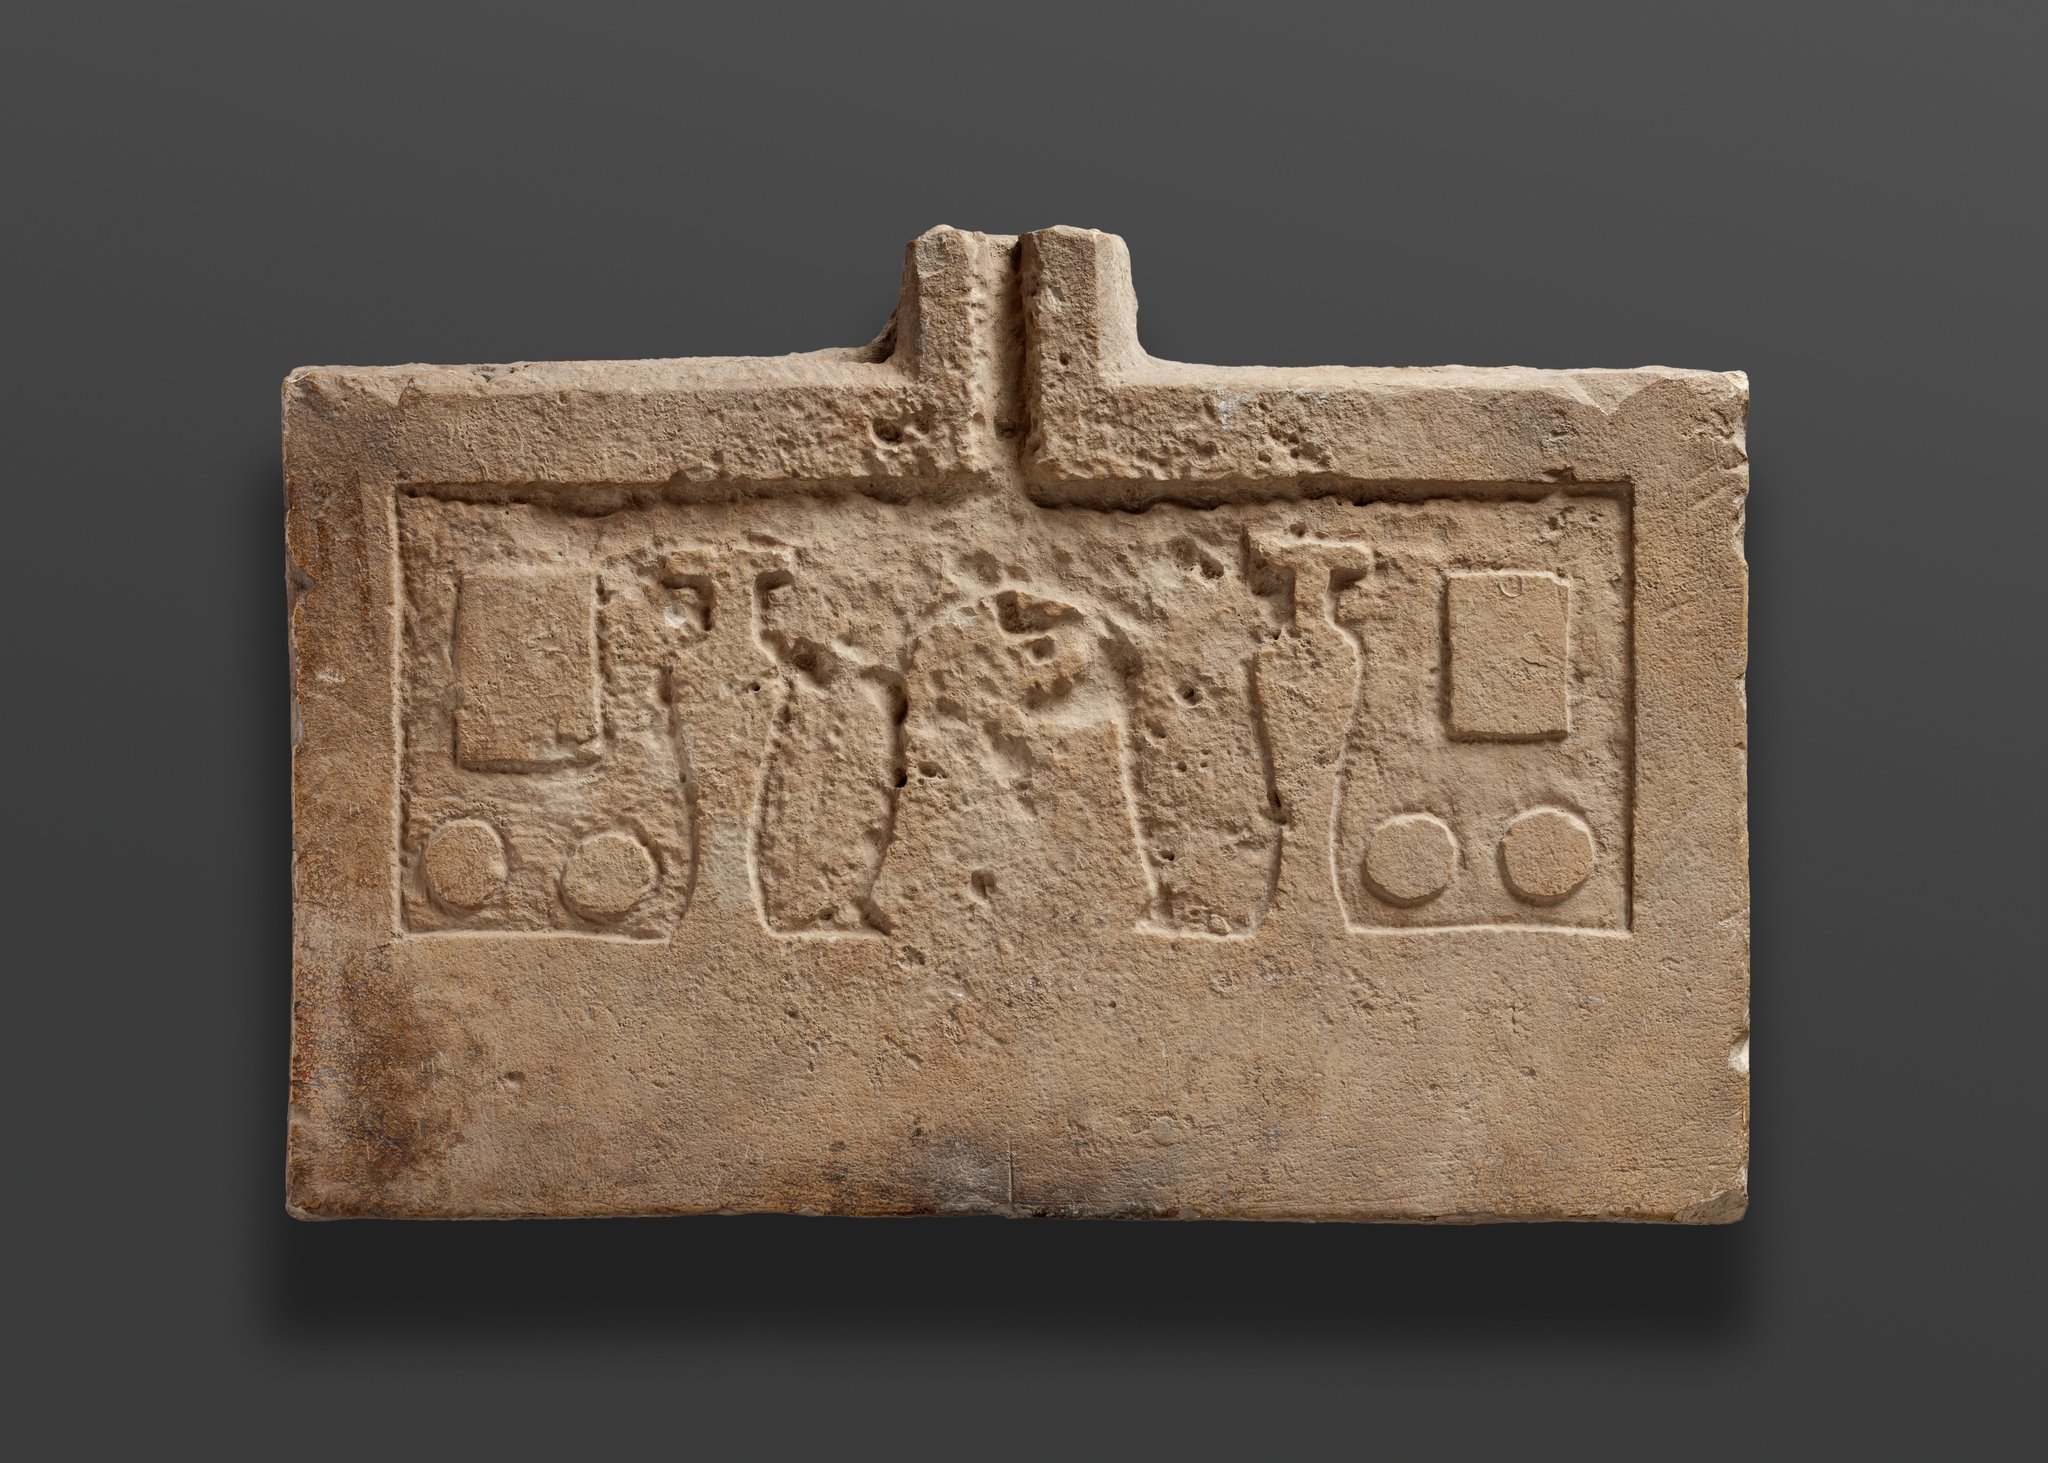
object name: offering table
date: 1900-1850 BCE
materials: limestone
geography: egypt